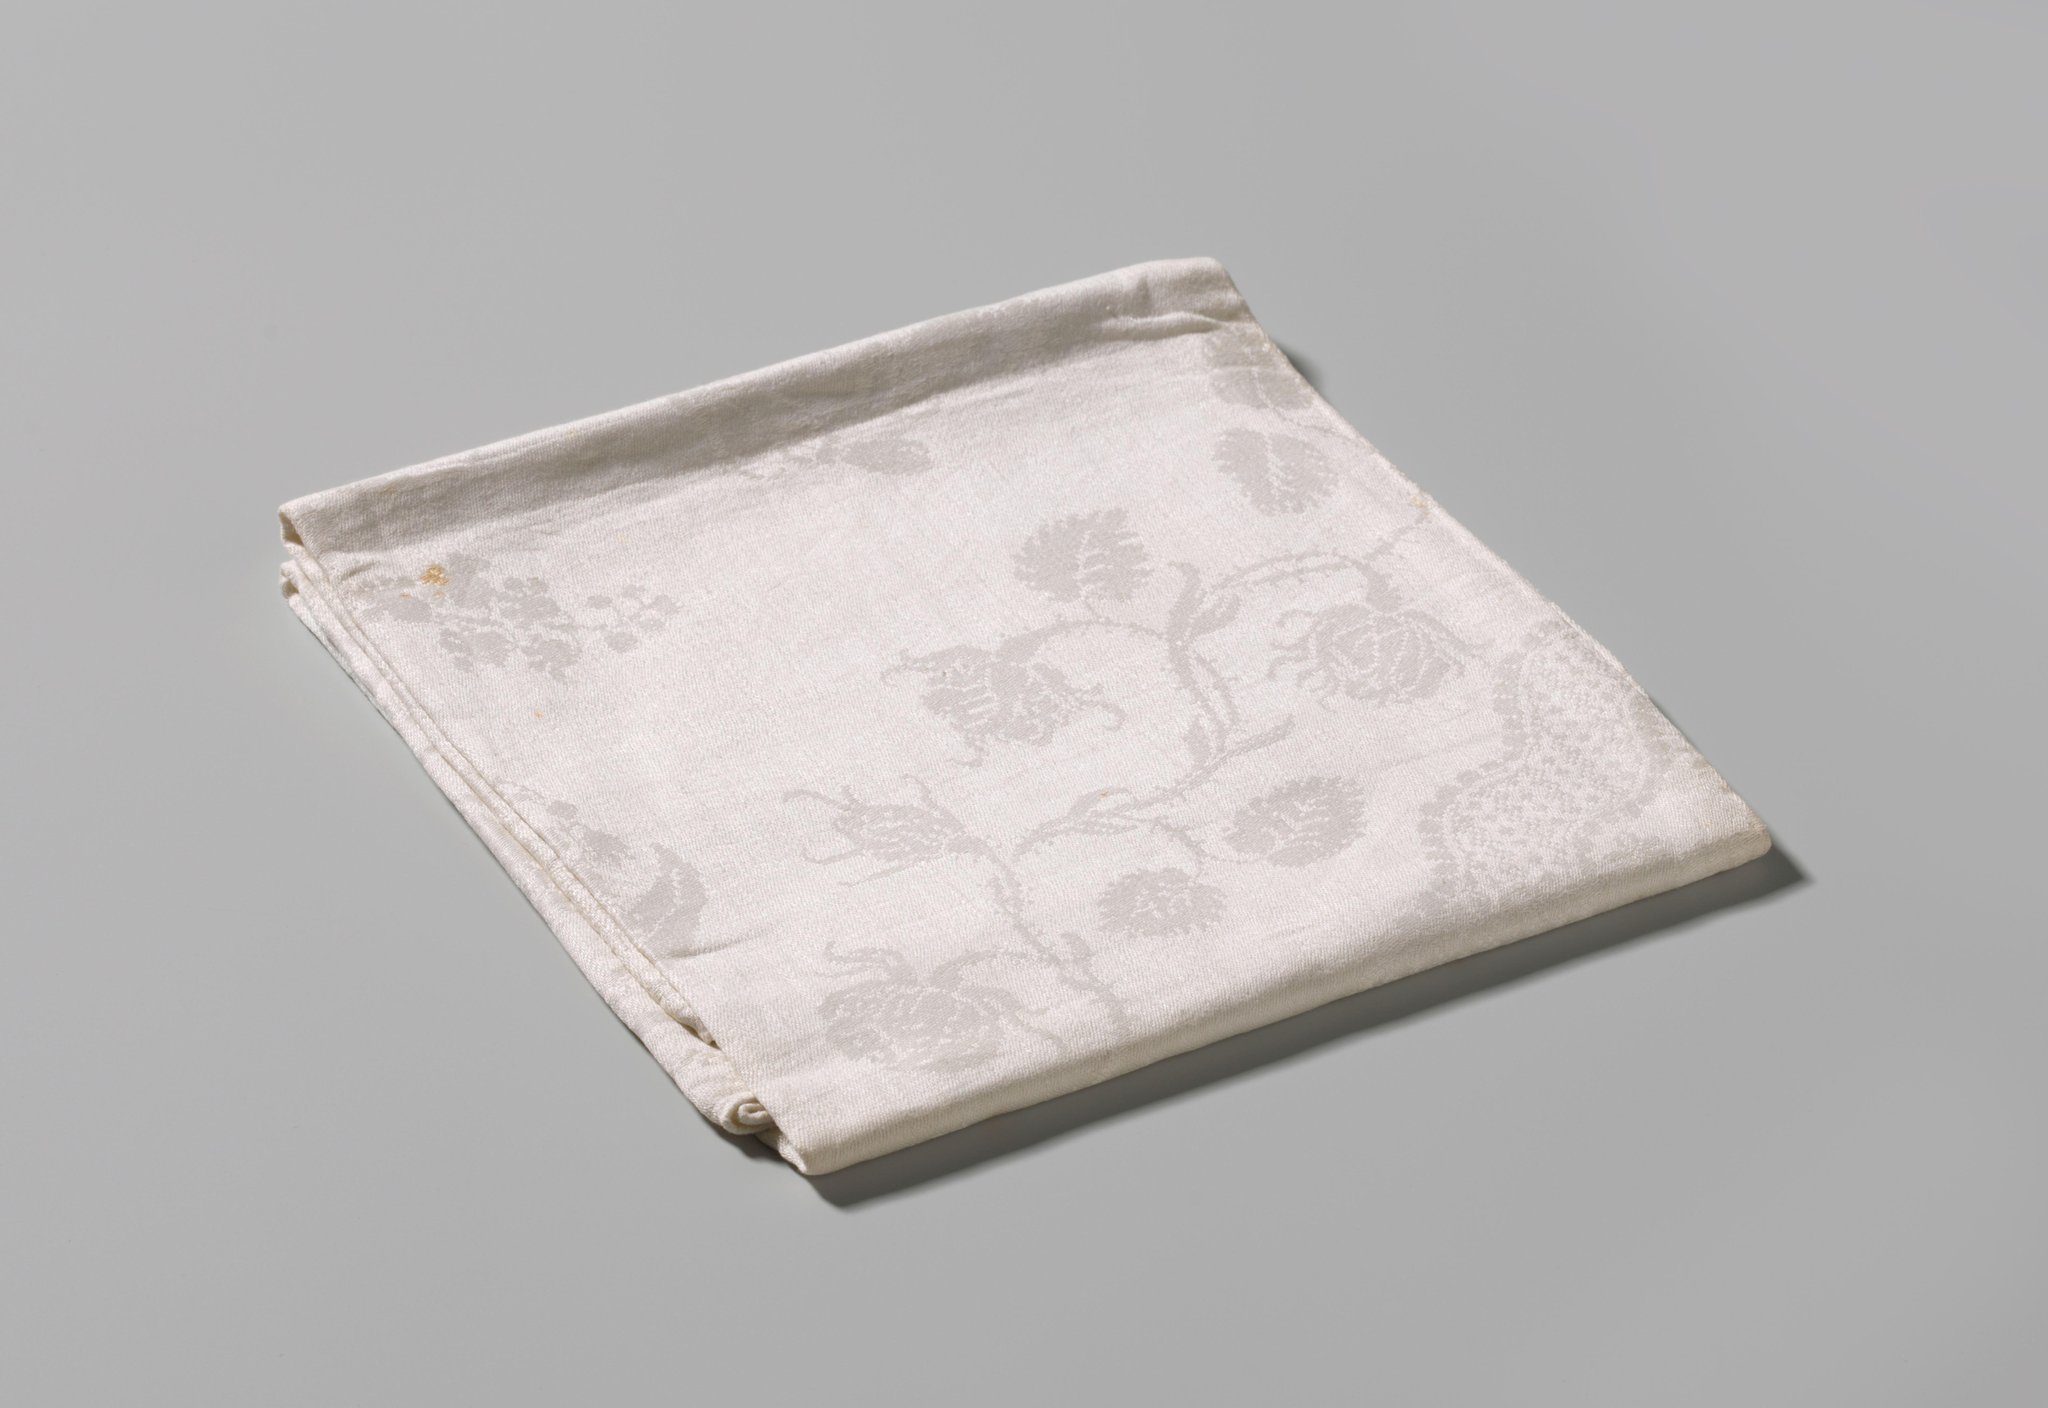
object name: napkin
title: Servet met krans en rozen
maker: Anonymous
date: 1700-1799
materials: linen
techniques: damask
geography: saxony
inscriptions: mark: ‘MH8’, monogram: ‘WPM’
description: Servet van linnendamast met krans van rozen. Het om verticale en horizontale as symmetrische patroon vertoont in het midden een ruitvormig met golvende lijst omgeven medaillon, waarin een middenrozet en sterren. Daaromheen een golvende gedoornde slingerende tak met rozenknoppen. Zonder overgang omrand door voluutranken met diverse bloemen en in de hoeken een schuingeplaatste bloemvaas, met C-contouren en gevuld met anjer, tulp, lelietje van dalen en lelie. Een smal fijn blokjesrandje omzoomt het geheel.